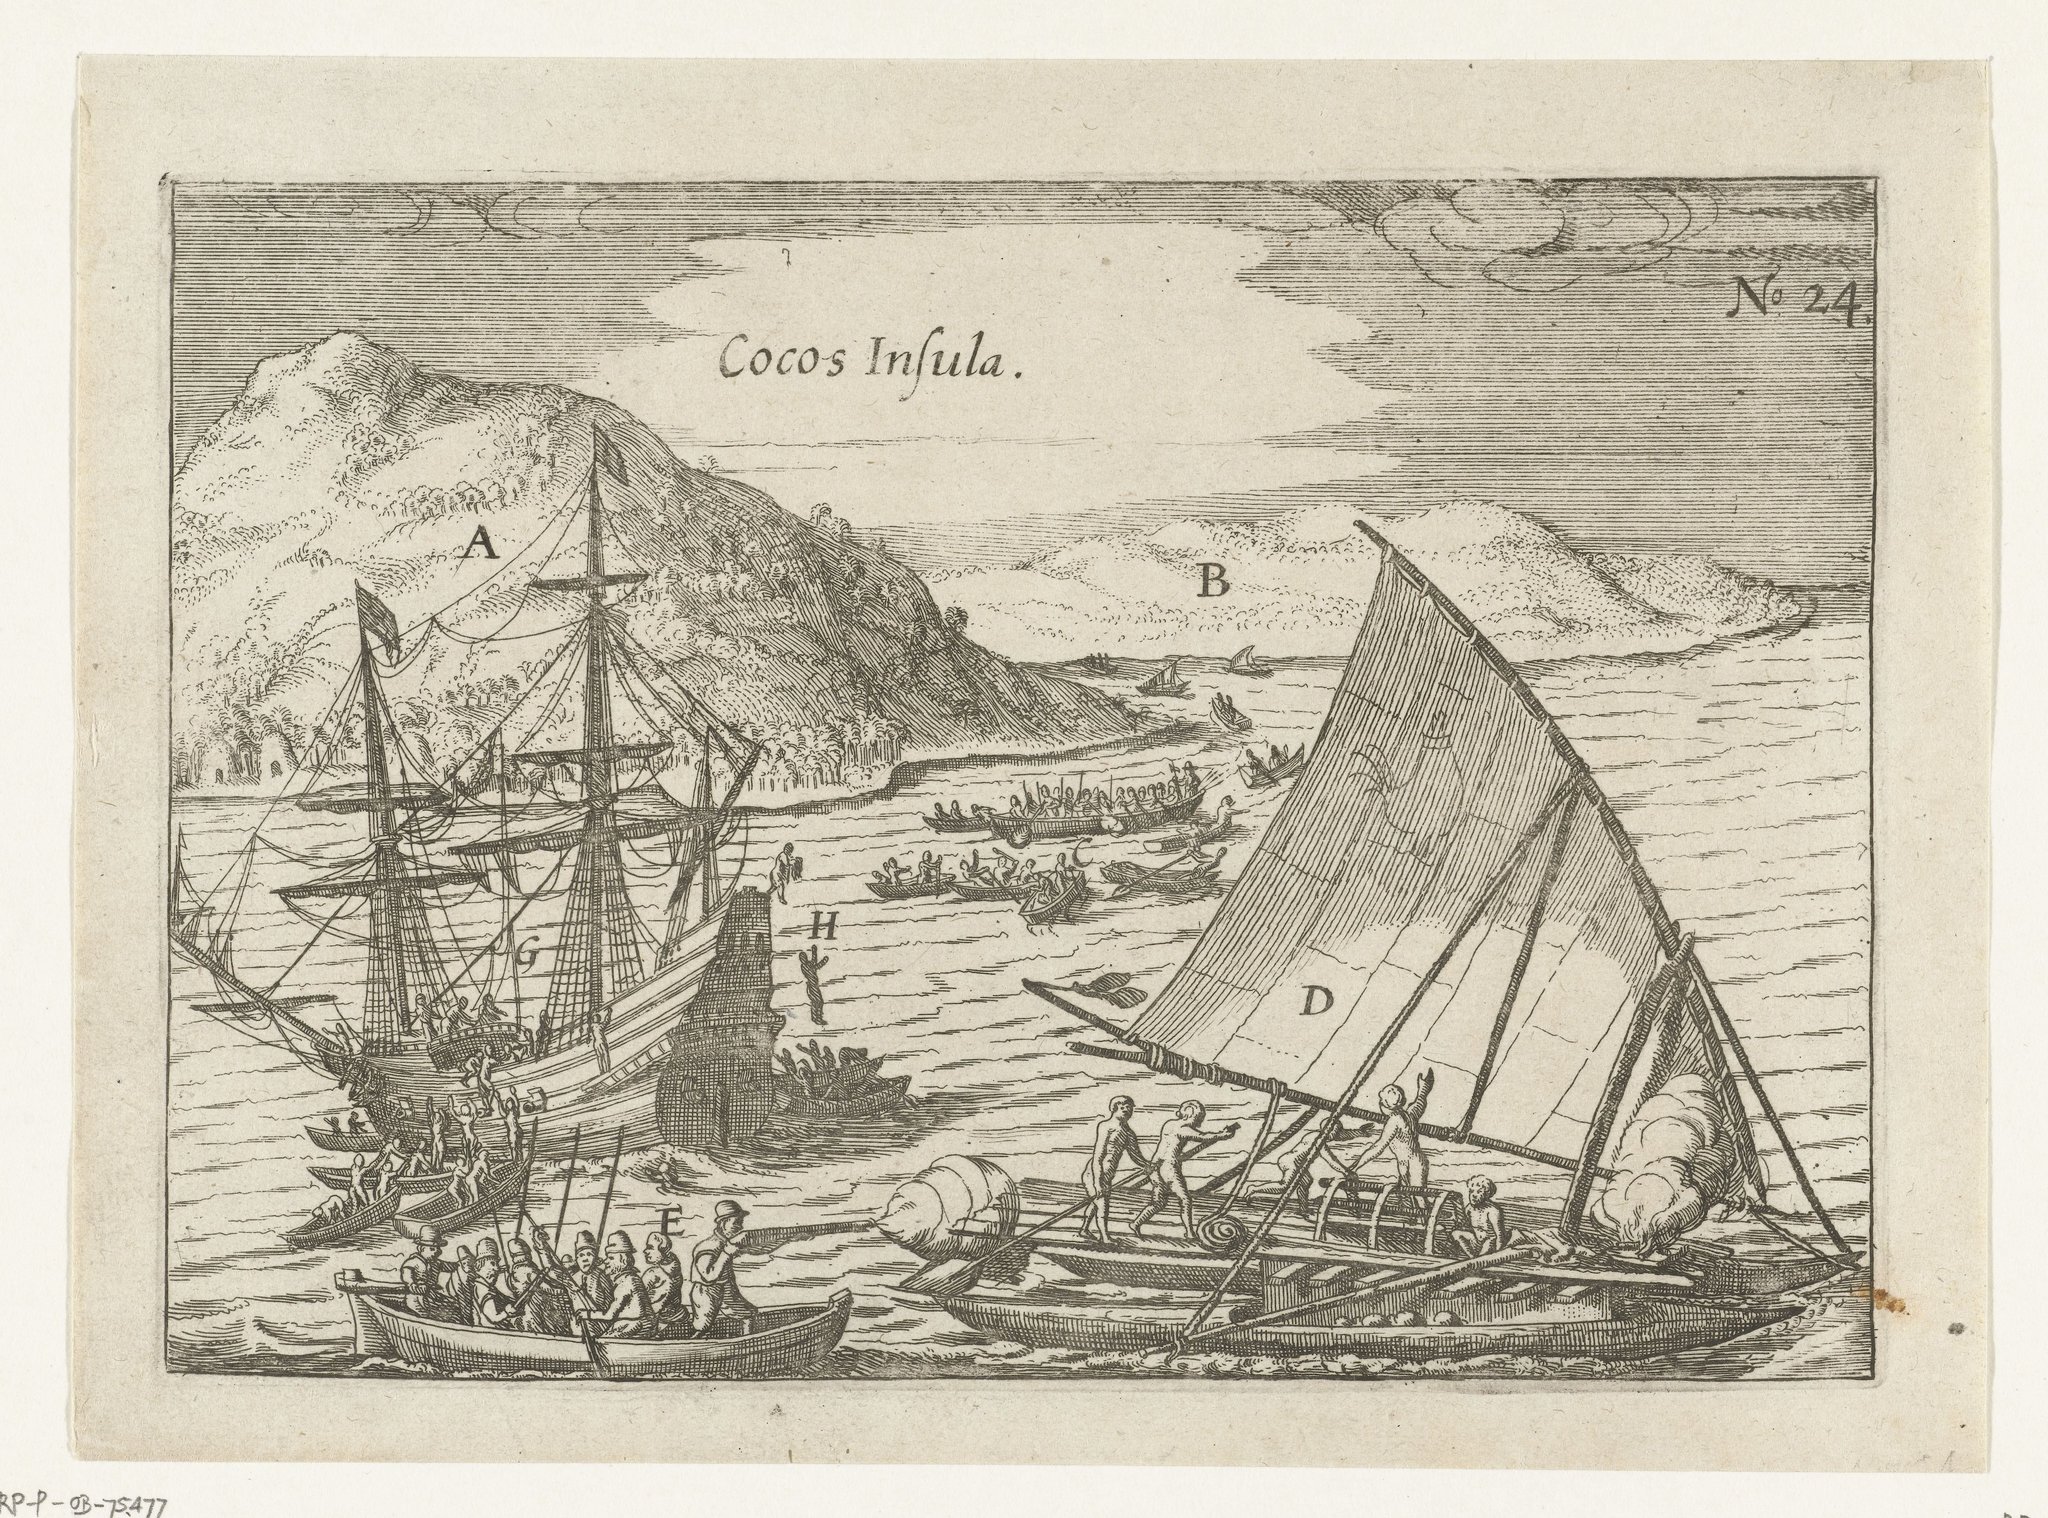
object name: print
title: Cocos Insula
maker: Anonymous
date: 1617-1619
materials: paper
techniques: etching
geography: northern netherlands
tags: antwerp, landscapes in tropical and sub-tropical regions, exploration, expedition, voyage of discovery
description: Oorspronkelijke illustraties eerst gebruikt in: Willem Cornelisz Schouten, Iovrnael ofte beschryvinghe van de wonderlijcke reyse, ghedaen door Willem Cornelisz Schouten van Hoorn, inde iaren 1615. 1616. en 1617, Willem Jansz Blaeu, Amsterdam, 1618. Kopieën naar deze platen gebruikt in: J. van Spilbergen, Oost ende West-Indische spiegel der 2 leste navigatiën, ghedaen inden jaeren 1614, 15, 16, 17, ende 18. daer in vertoont woort, in wat gestalt Ioris van Speilbergen door de Magellanes de werelt rontom geseylt heeft ...; met de Australische navigatiën, van Iacob le Maire, ... met veel wonders ... in 26 coperen platen afghebeelt, N. Geelkerck, Leiden 1619. Later opnieuw gebruikt in : I. Commelin, Begin ende voortgangh, van de Vereenighde Nederlantsche Geoctroyeerde Oost-Indische Compagnie, J. Janssonius, Amsterdam 1646. Genummerd: No. 24.